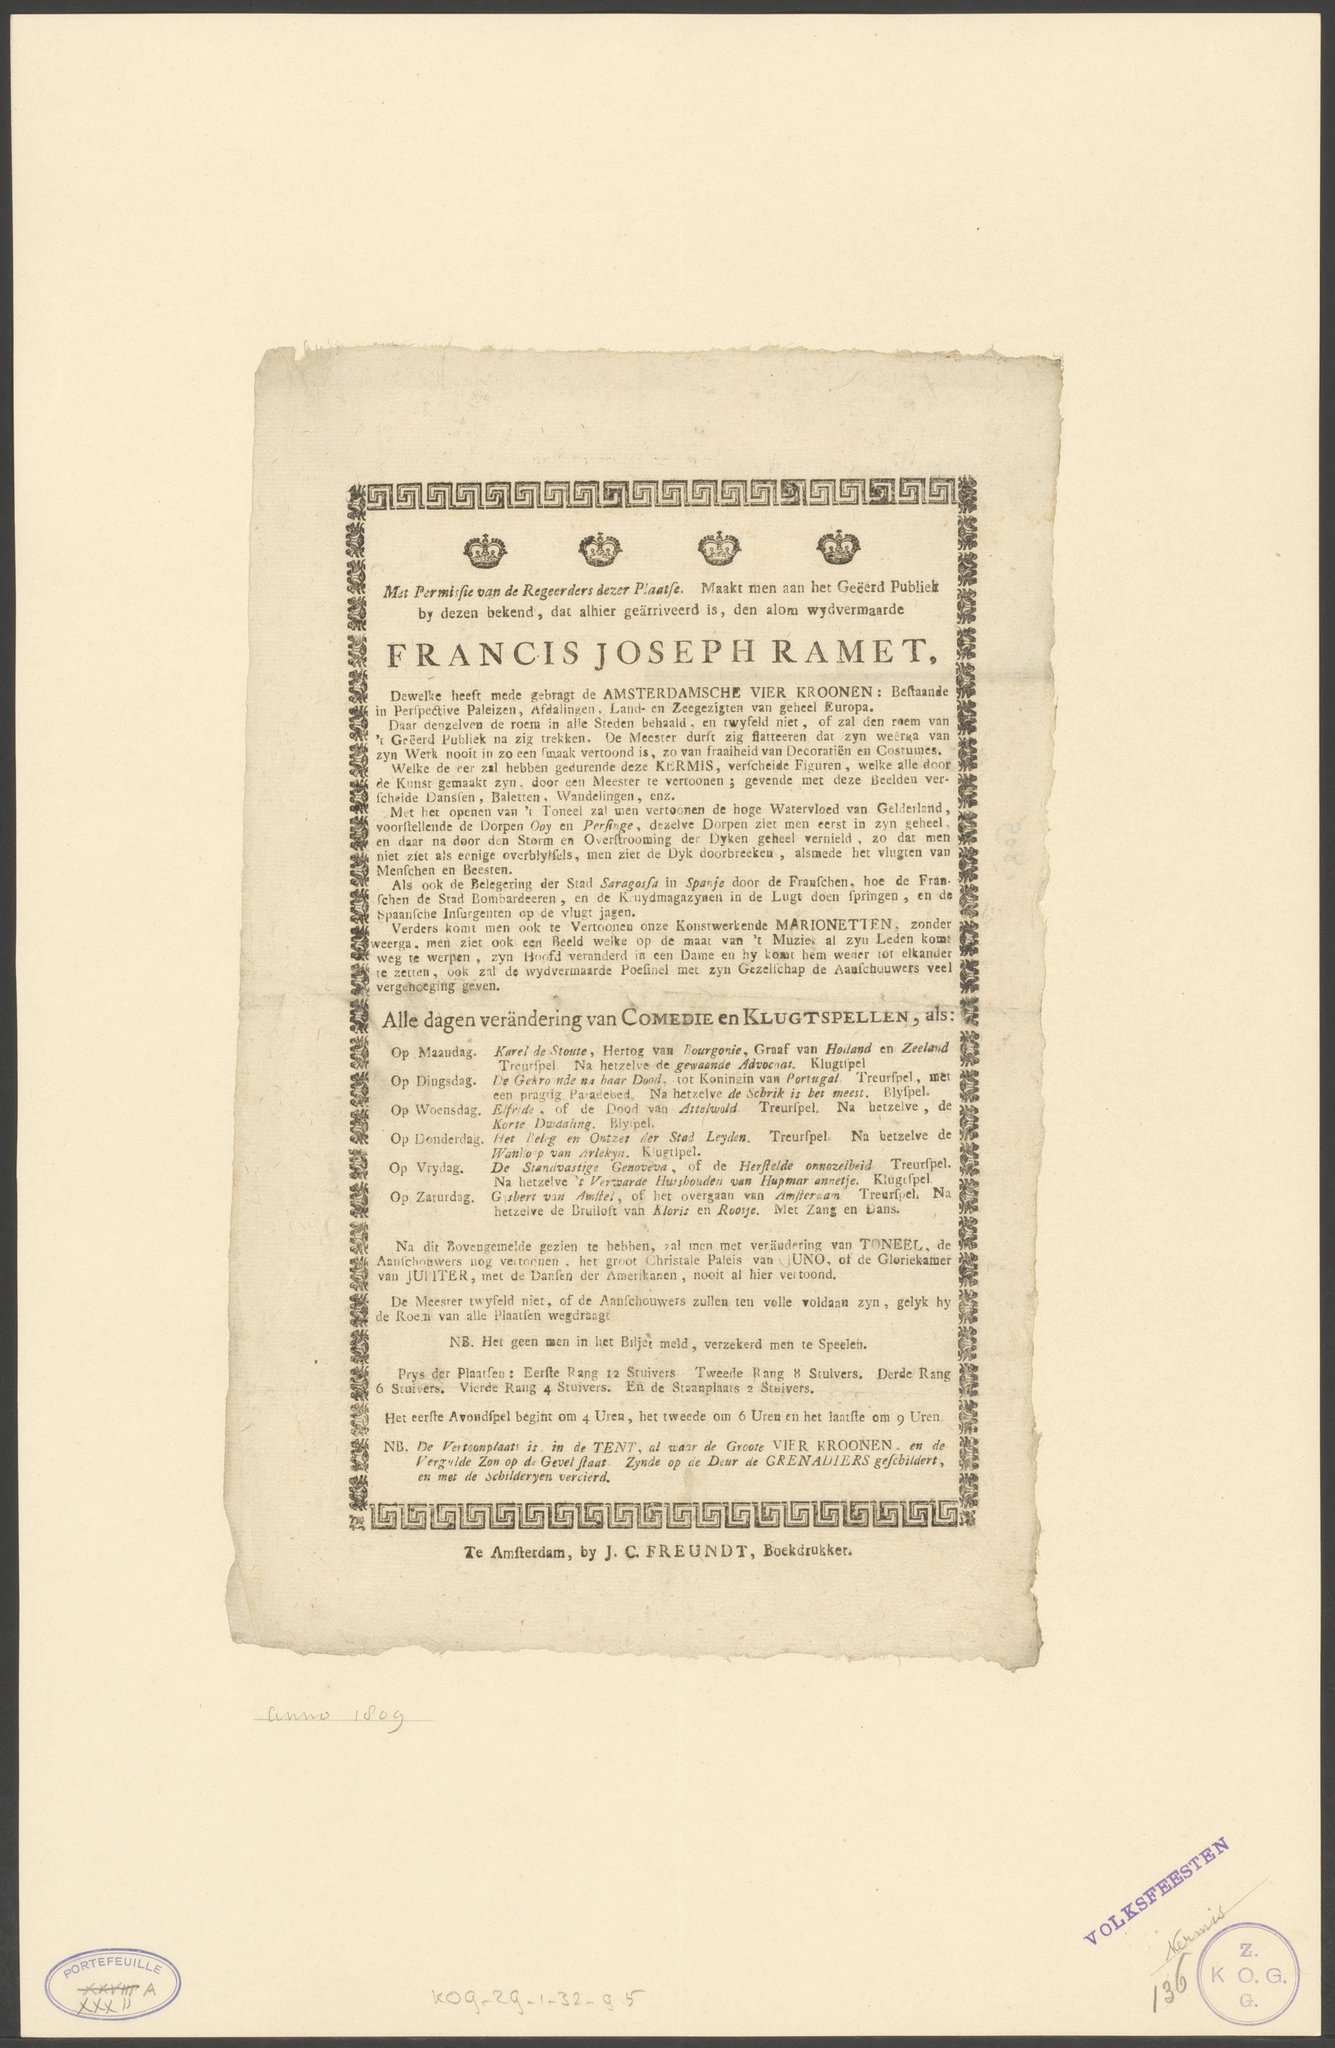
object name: reclamebiljet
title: Francis Joseph Ramet, Dewelke heeft mede gebragt de Amsterdamsche Vier Kroonen: Bestaande in Perspective Paleizen, Afdalingen, Land- en Zeegezigten van geheel Europa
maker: freundt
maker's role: printer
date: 1809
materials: paper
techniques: letterpress printing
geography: amsterdam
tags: marionette, pleasure fair and circus, amsterdam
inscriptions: collector's mark, collector's mark: Lugt 1641